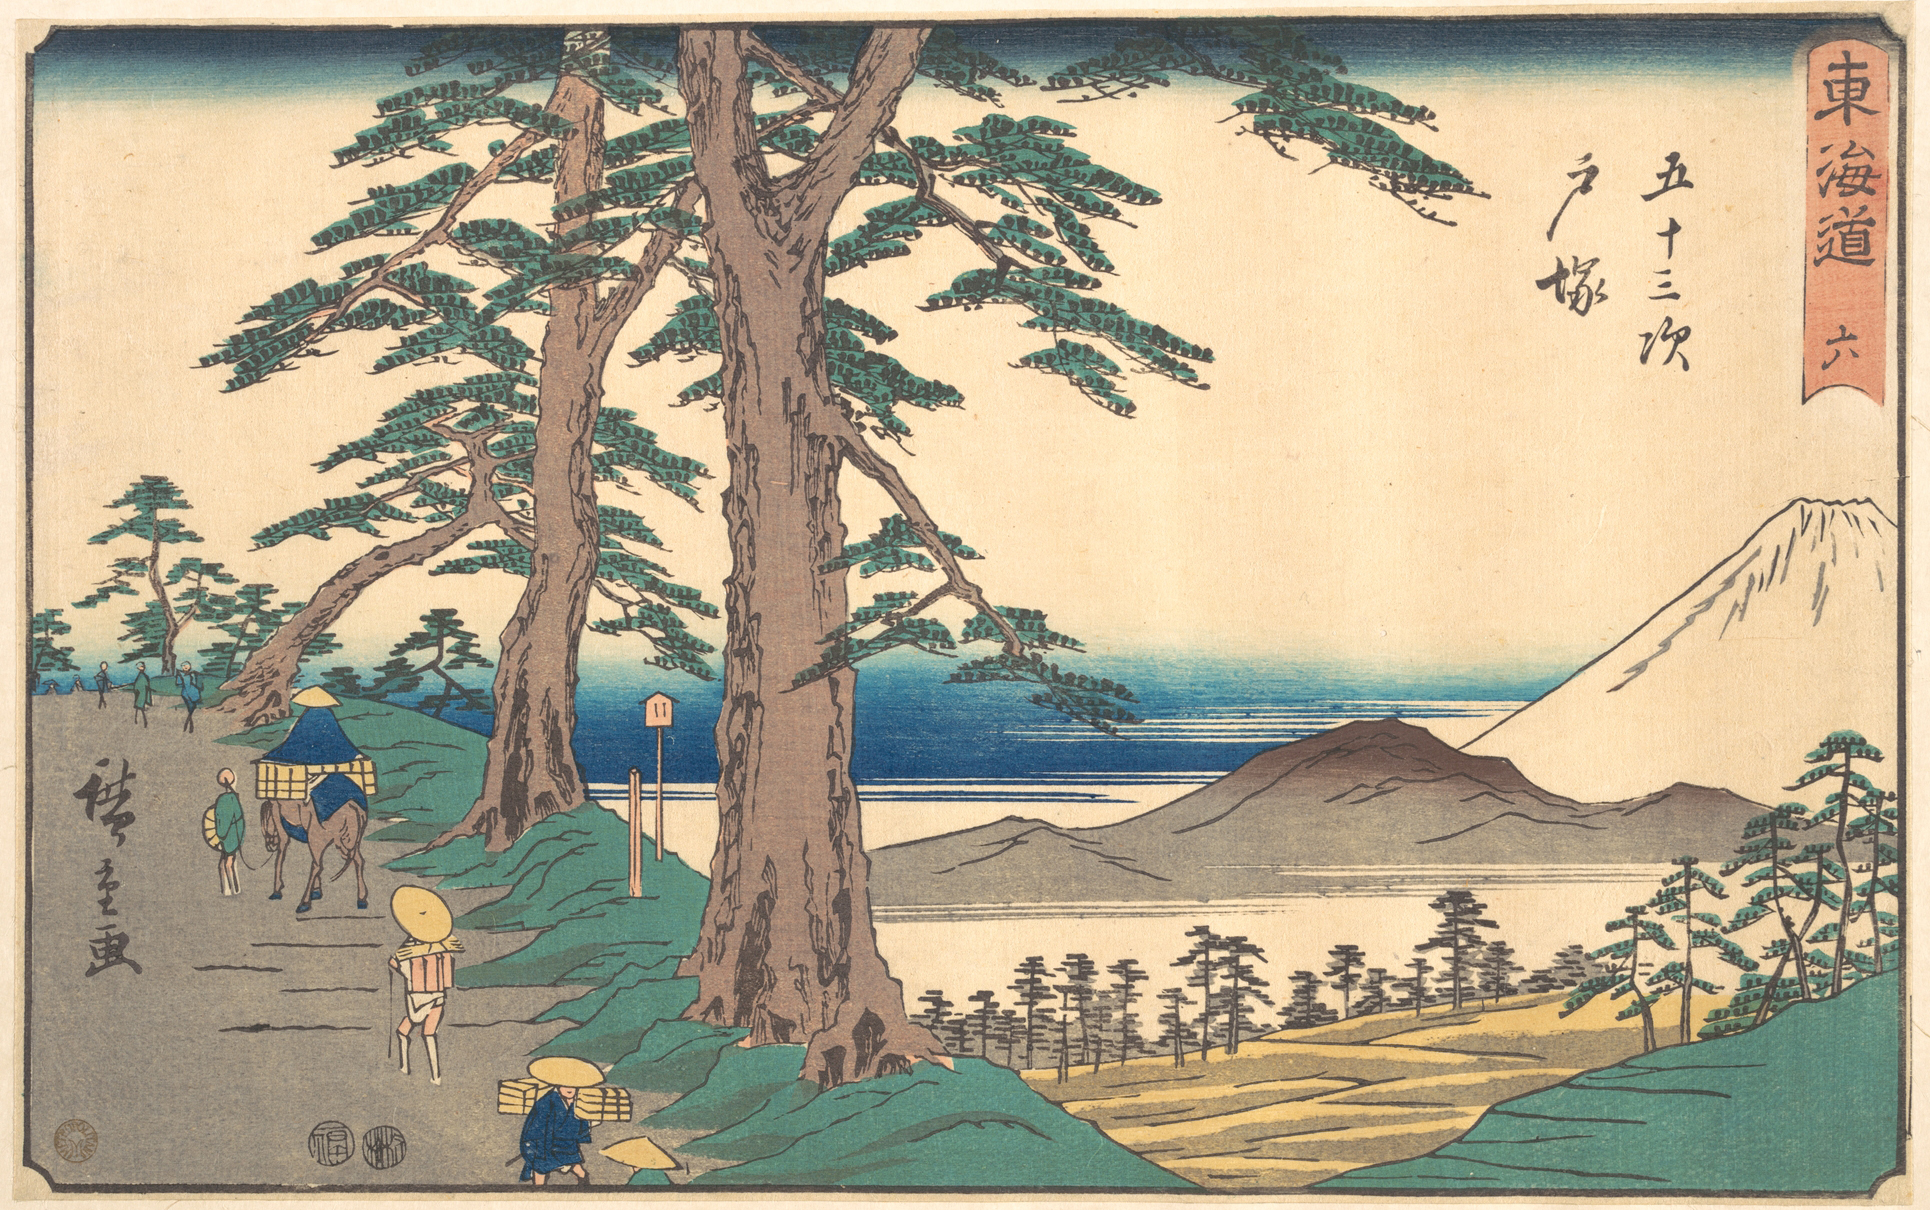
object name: print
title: Totsuka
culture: japanese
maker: utagawa hiroshige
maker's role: artist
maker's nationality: japanese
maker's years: 1797-1858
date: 1840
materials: ink, paper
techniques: woodblock print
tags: human figures,mountains,trees